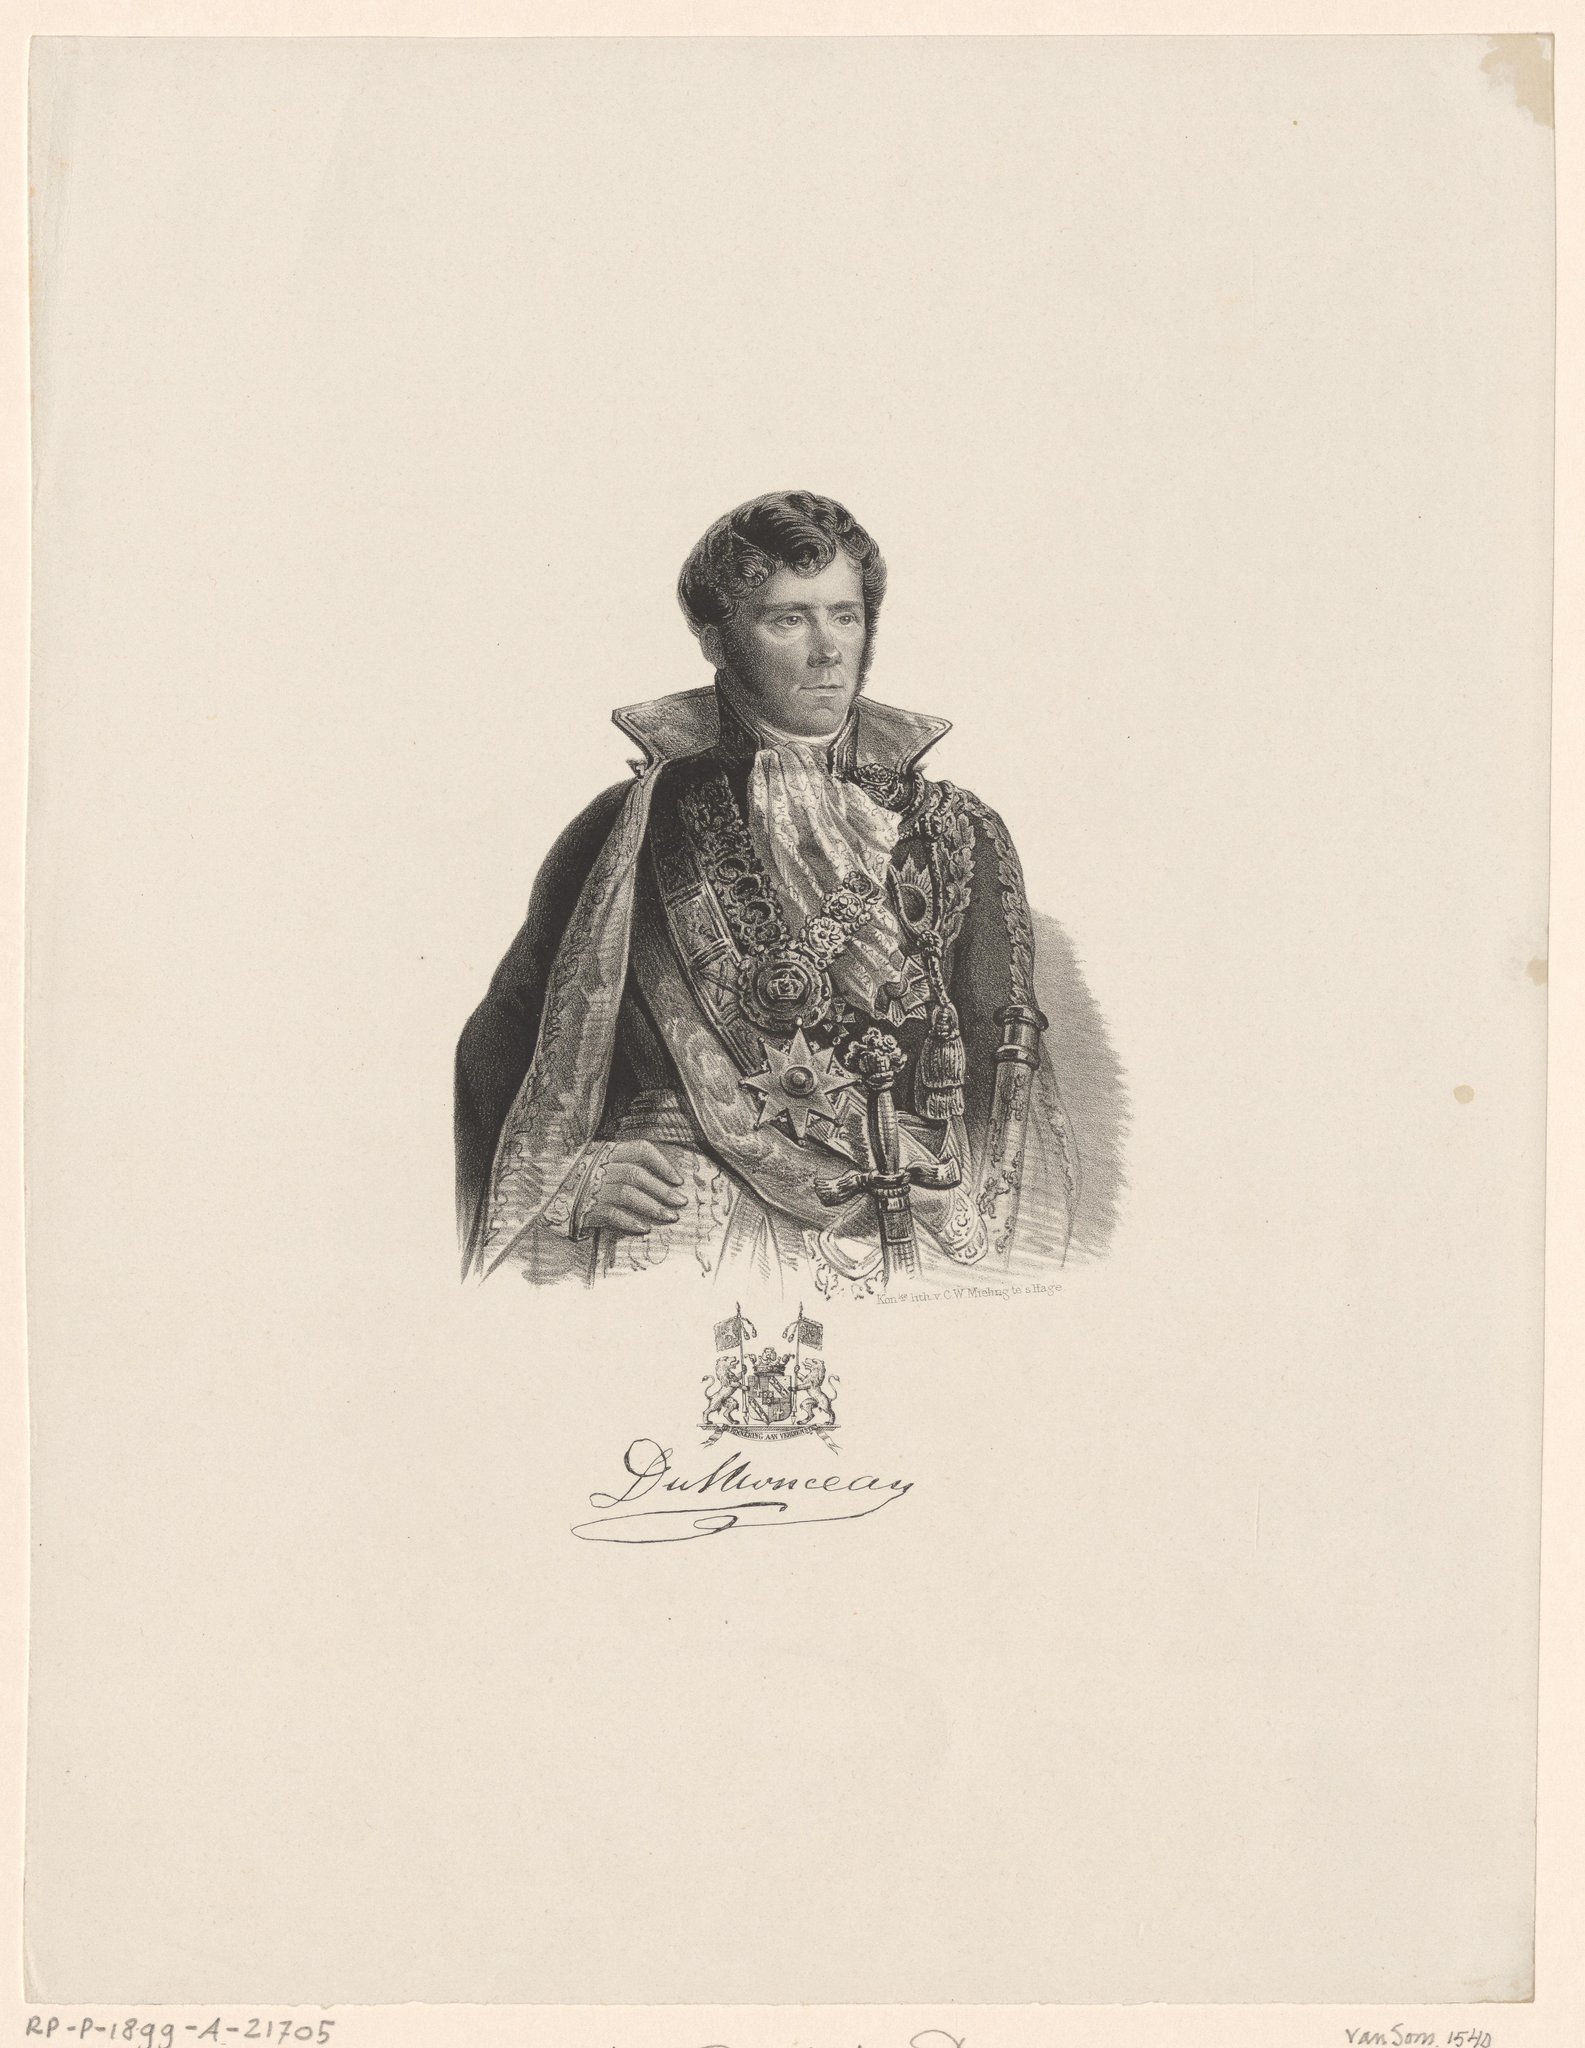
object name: print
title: Portret van graaf Jean-Baptiste Dumonceau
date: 1852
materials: paper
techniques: lithograph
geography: the hague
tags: brussels, commander-in-chief, general, marshal, historical persons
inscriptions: collector's mark: Lugt 2228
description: Prent ook gebruikt in: Sypesteyn, Jan Willem van. Het leven en karakter van J. B. Graaf du Monceau, Oud-Maarschalk van Holland (...). Den Bosch: gebroeders Muller, 1852.